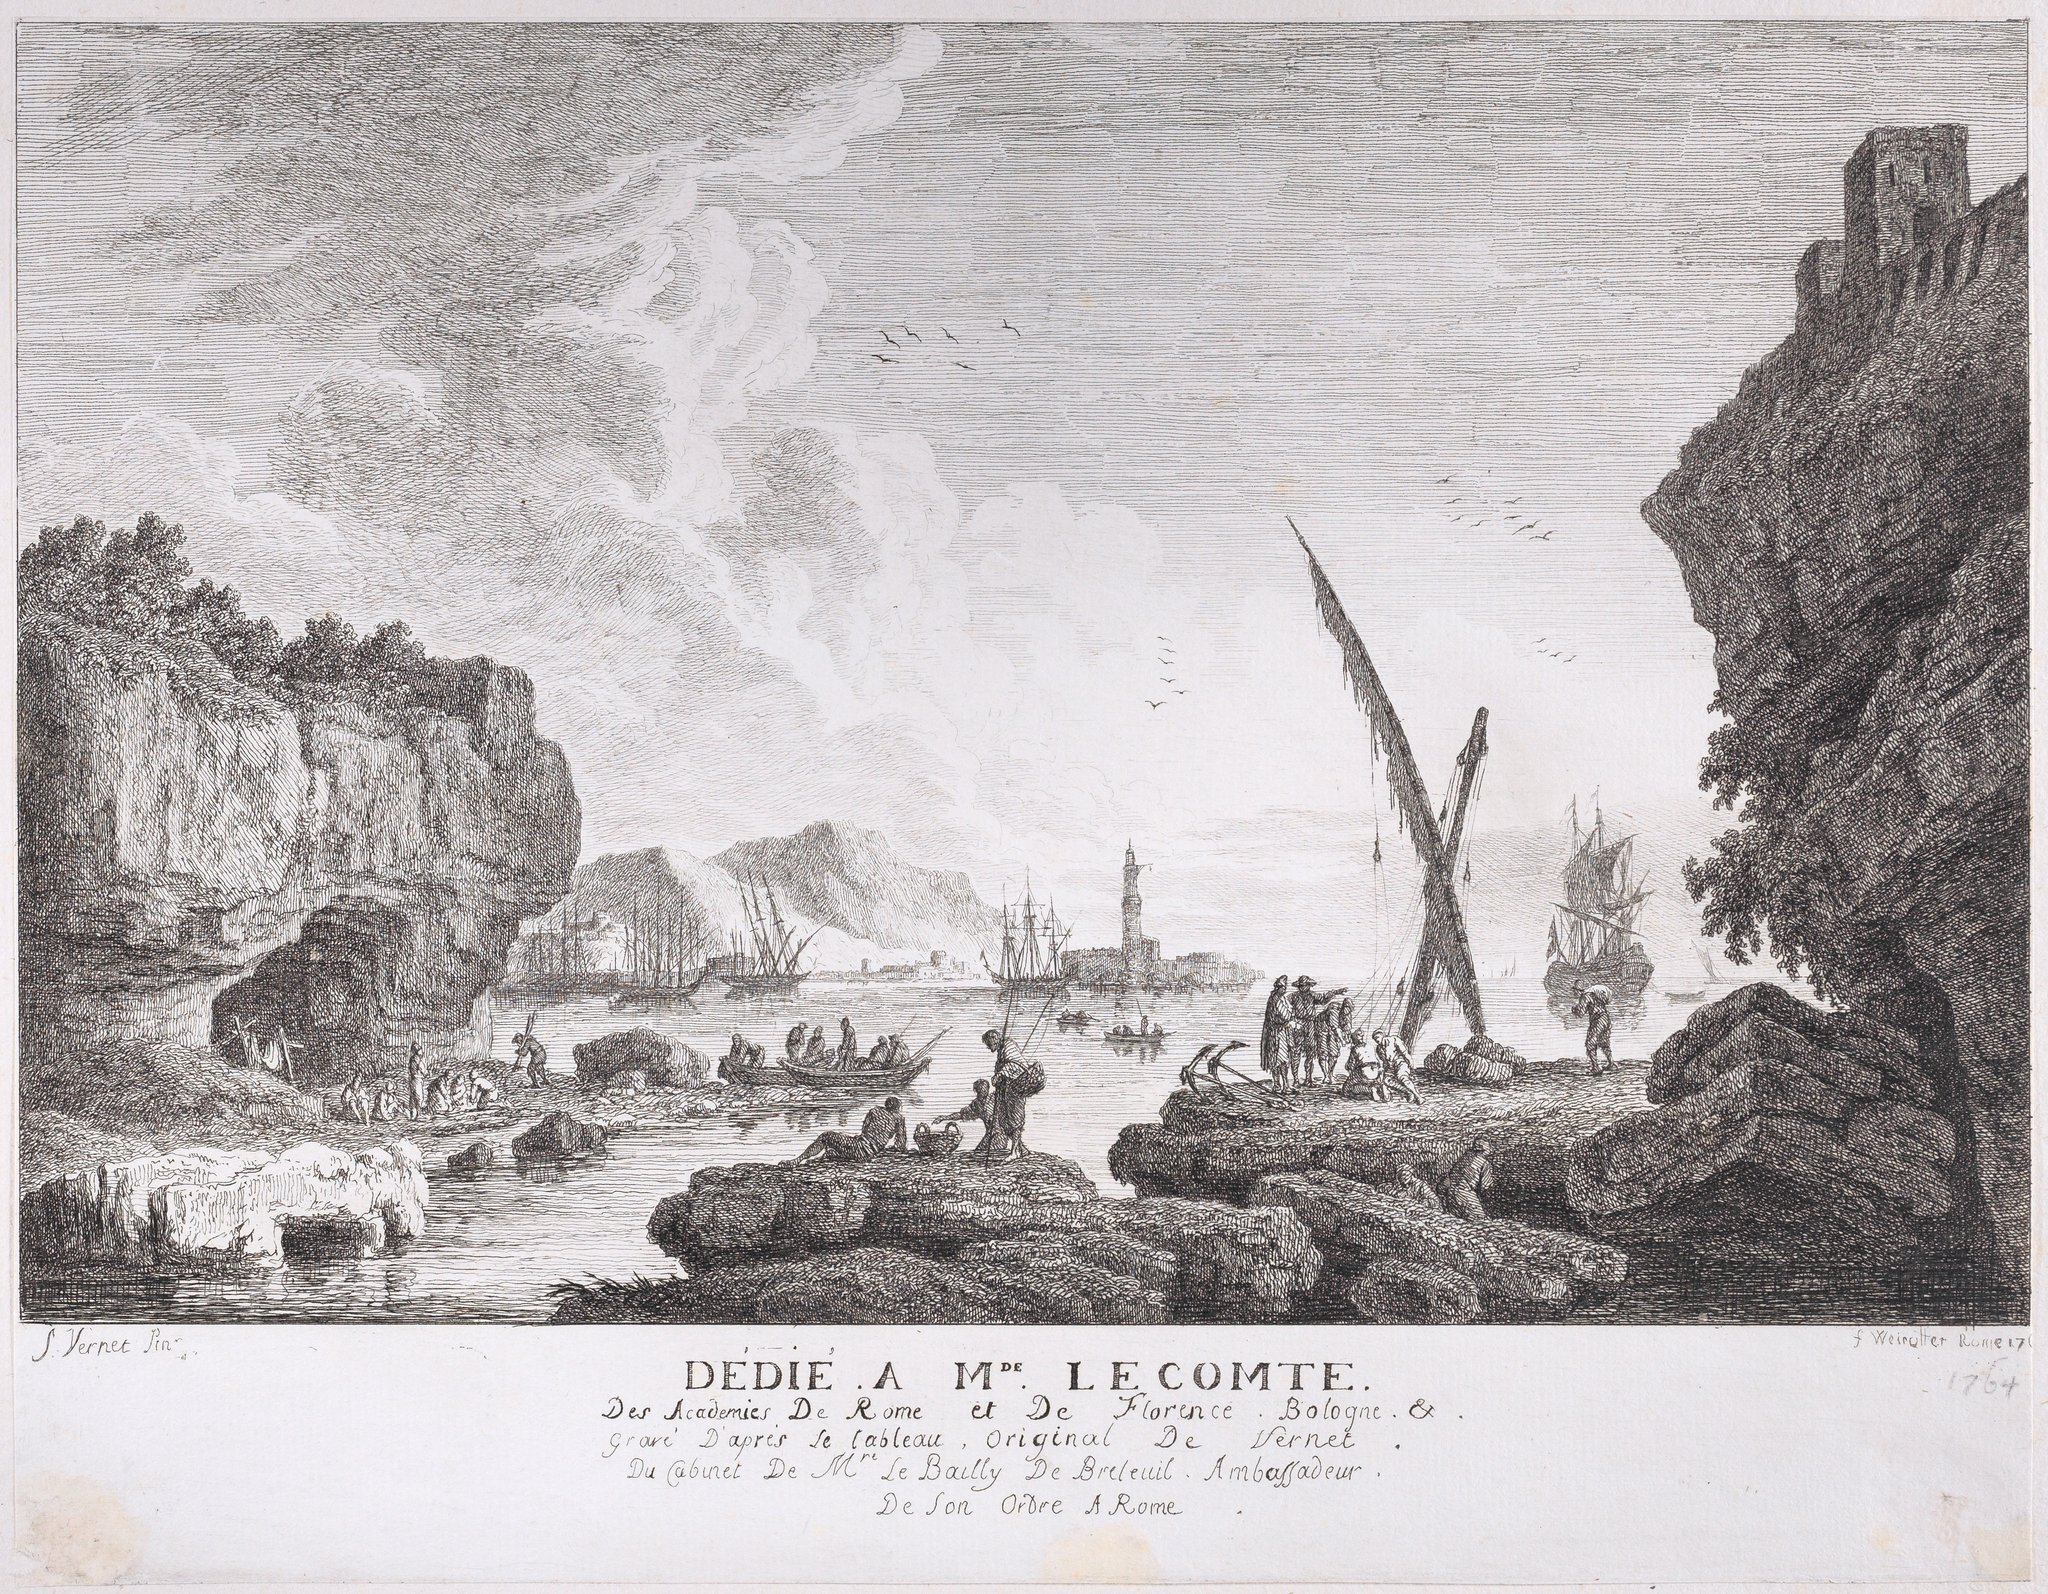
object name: print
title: Harbor Scene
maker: joseph vernet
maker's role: artist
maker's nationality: french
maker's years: 1714-1789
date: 1764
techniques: etching